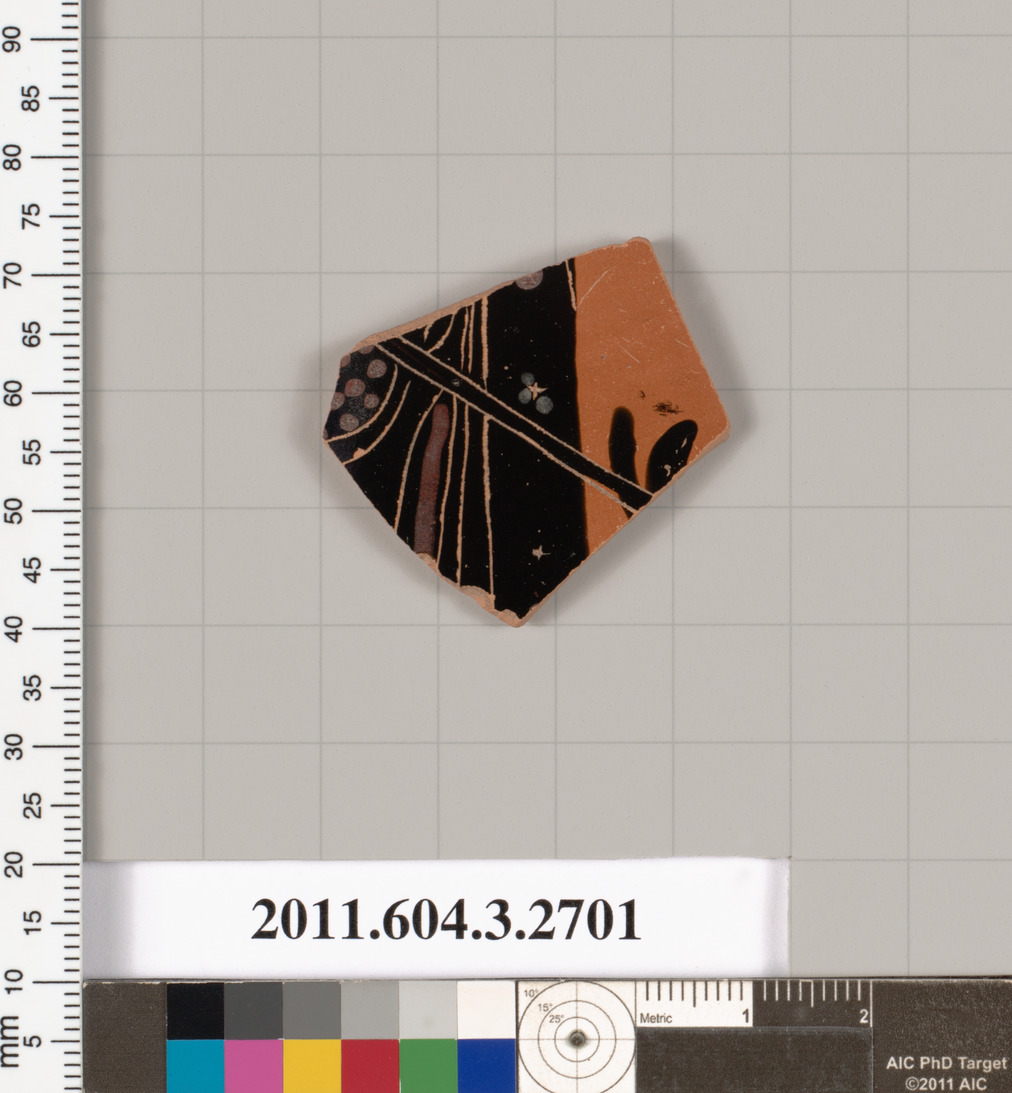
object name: oinochoe or olpe fragment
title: Terracotta fragment of an oinochoe (jug) or olpe (jug)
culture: greek, attic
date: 510-500 BCE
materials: terracotta